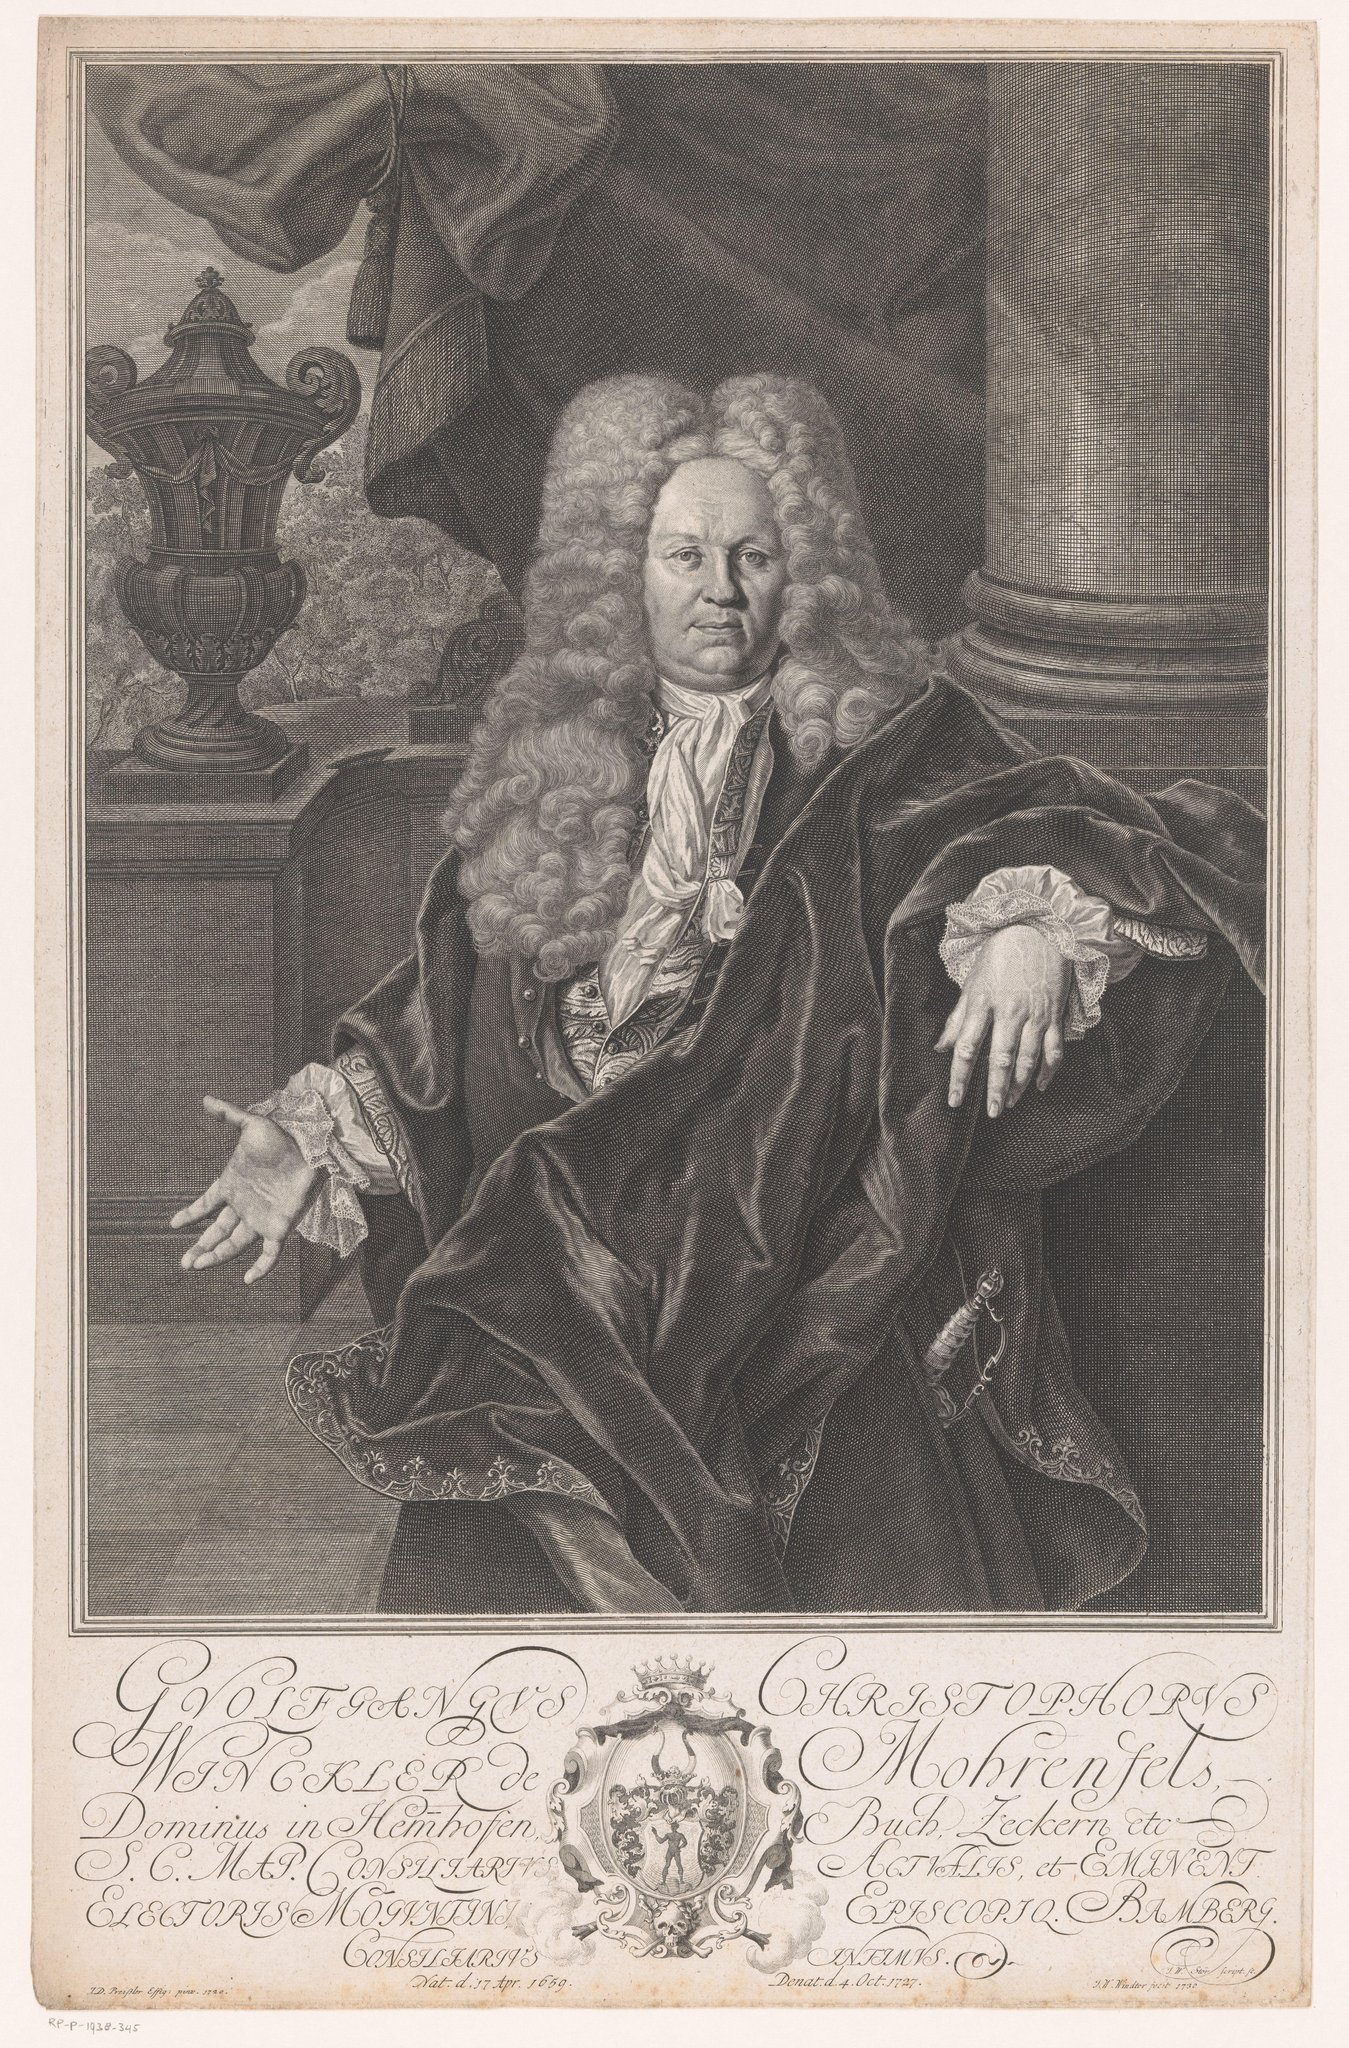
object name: print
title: Portret van Wolfgang Christoph Winkler von Mohrenfels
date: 1730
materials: paper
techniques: engraving, etching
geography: germany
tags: historical persons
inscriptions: collector's mark: Lugt 2228